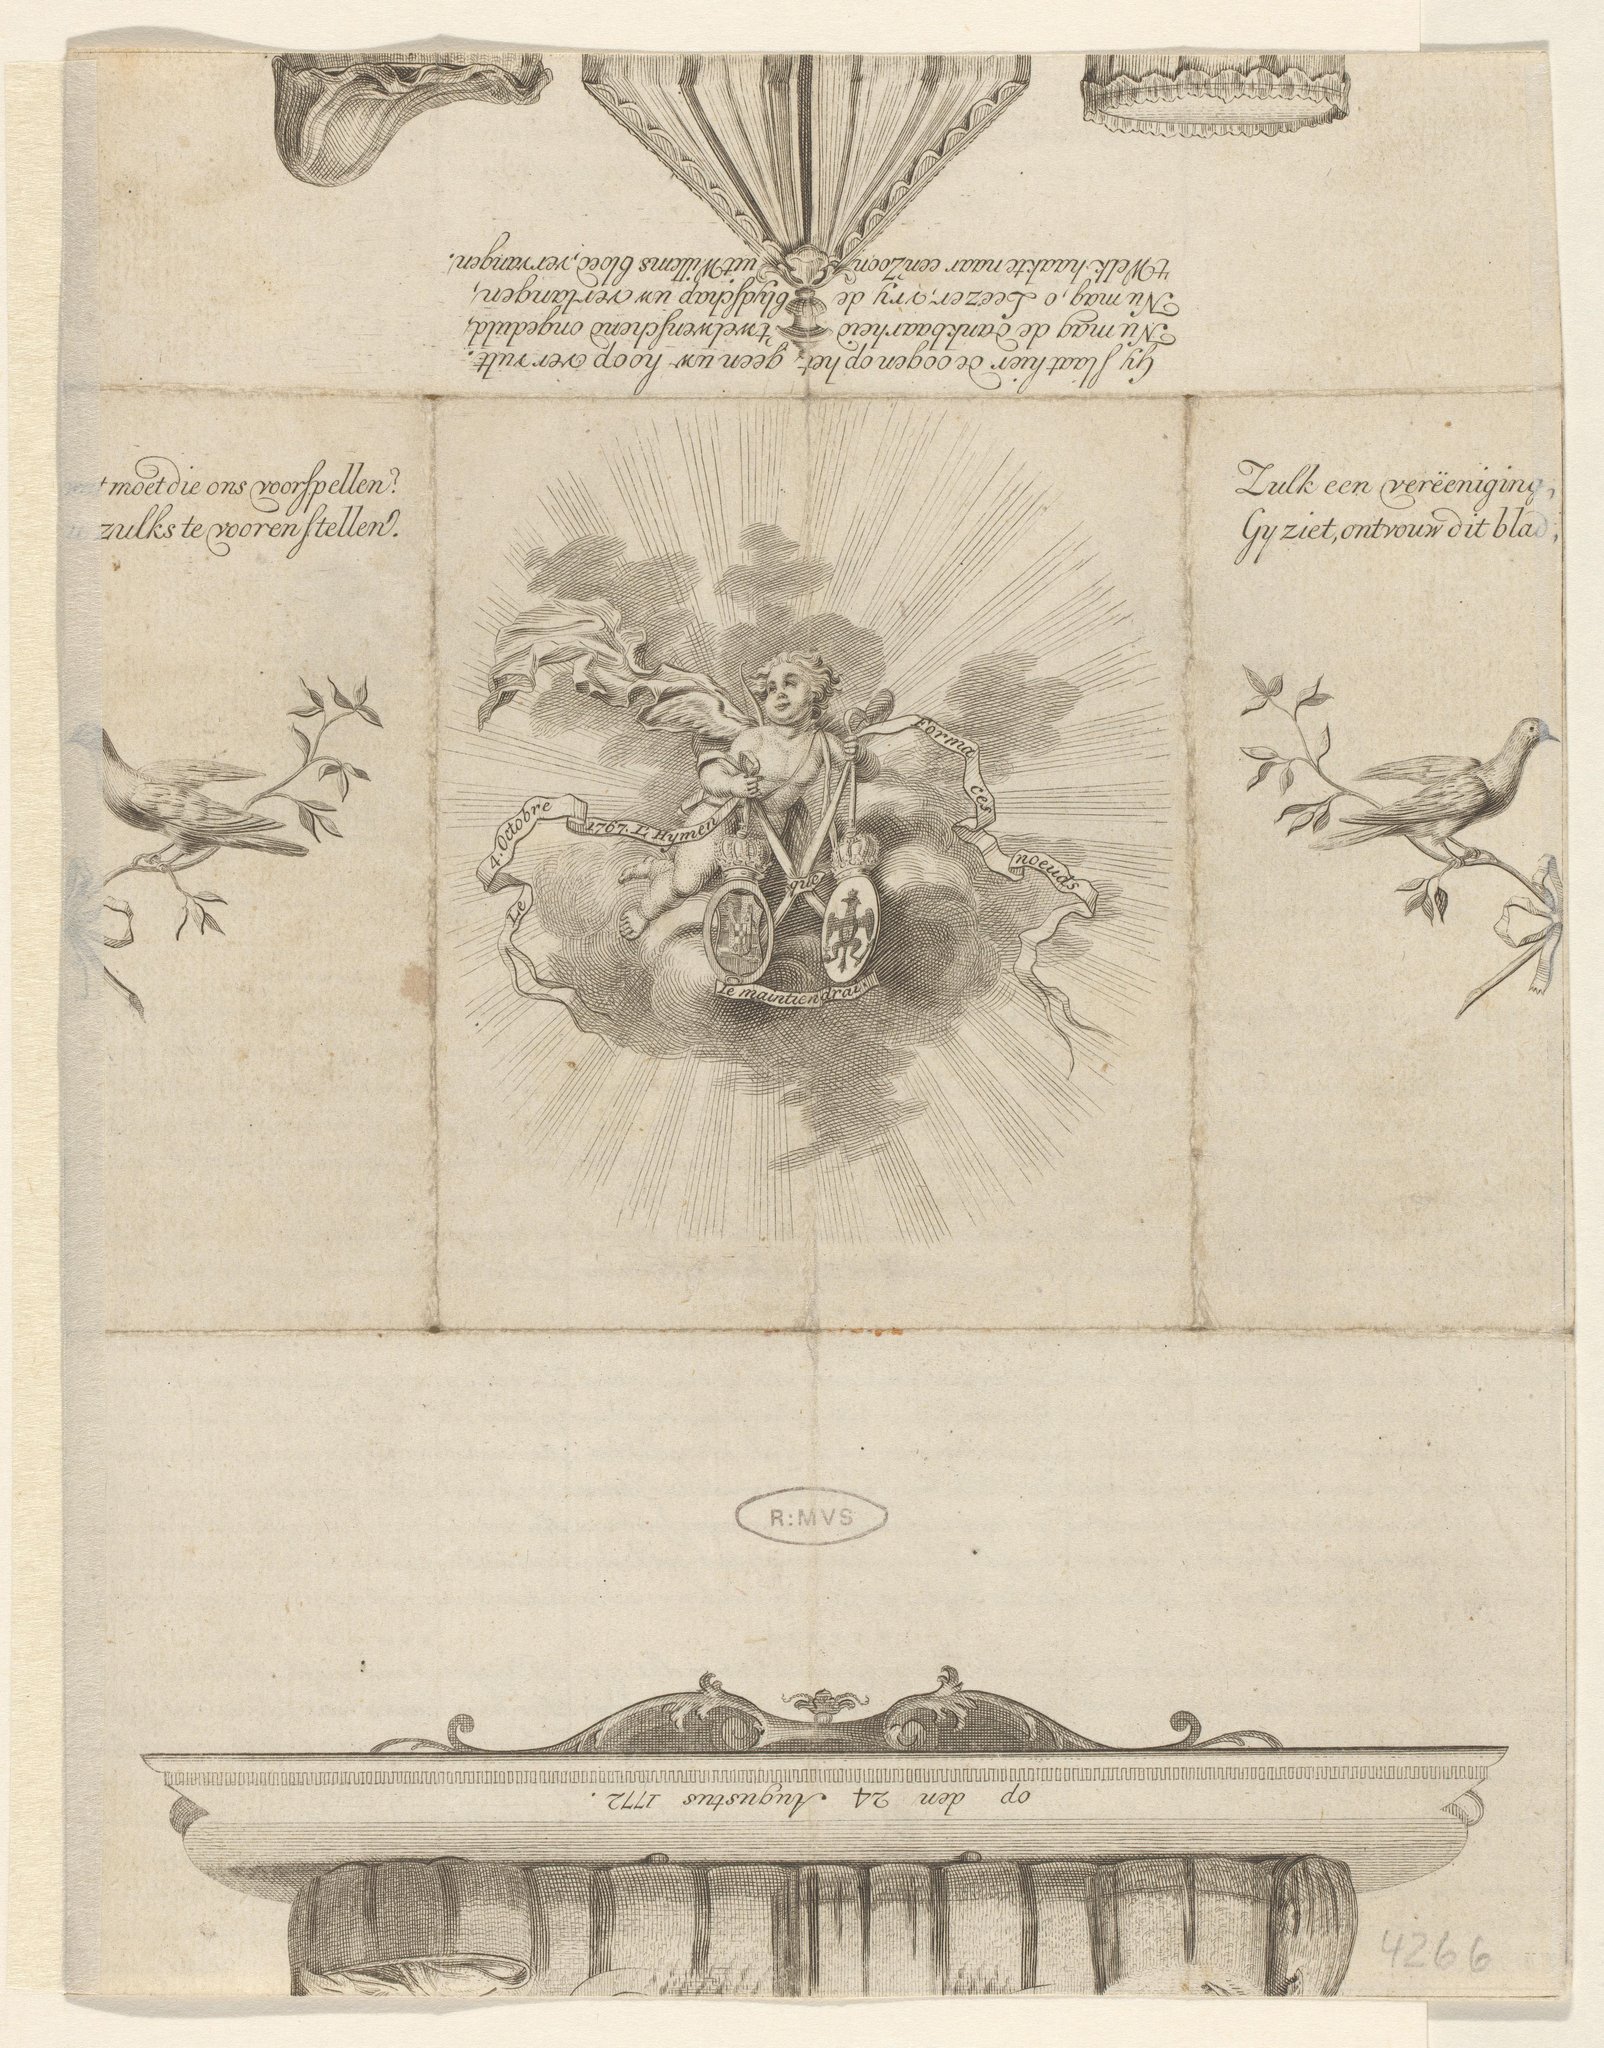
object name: print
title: Vouwprent met allegorie op de geboorte van prins Willem Frederik, 1772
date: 1772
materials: paper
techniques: engraving, etching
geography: northern netherlands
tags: william v (prince of orange), the hague, berlin, william i of the netherlands, draughtsman, wilhelmina of prussia (princess of orange), dry-nurse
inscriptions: collector's mark: Lugt 2228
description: Buitenkant van een openvouwbaar blad over de geboorte van prins Willem Frederik op 24 augustus 1772. Centraal een putto met de wapens van Willem V en Wilhelmina van Pruisen, links en rechts duiven op een tak met een strik. Boven en onder delen van een wieg, met een vierregelig vers in het Nederlands en de geboortedatum van de prins.